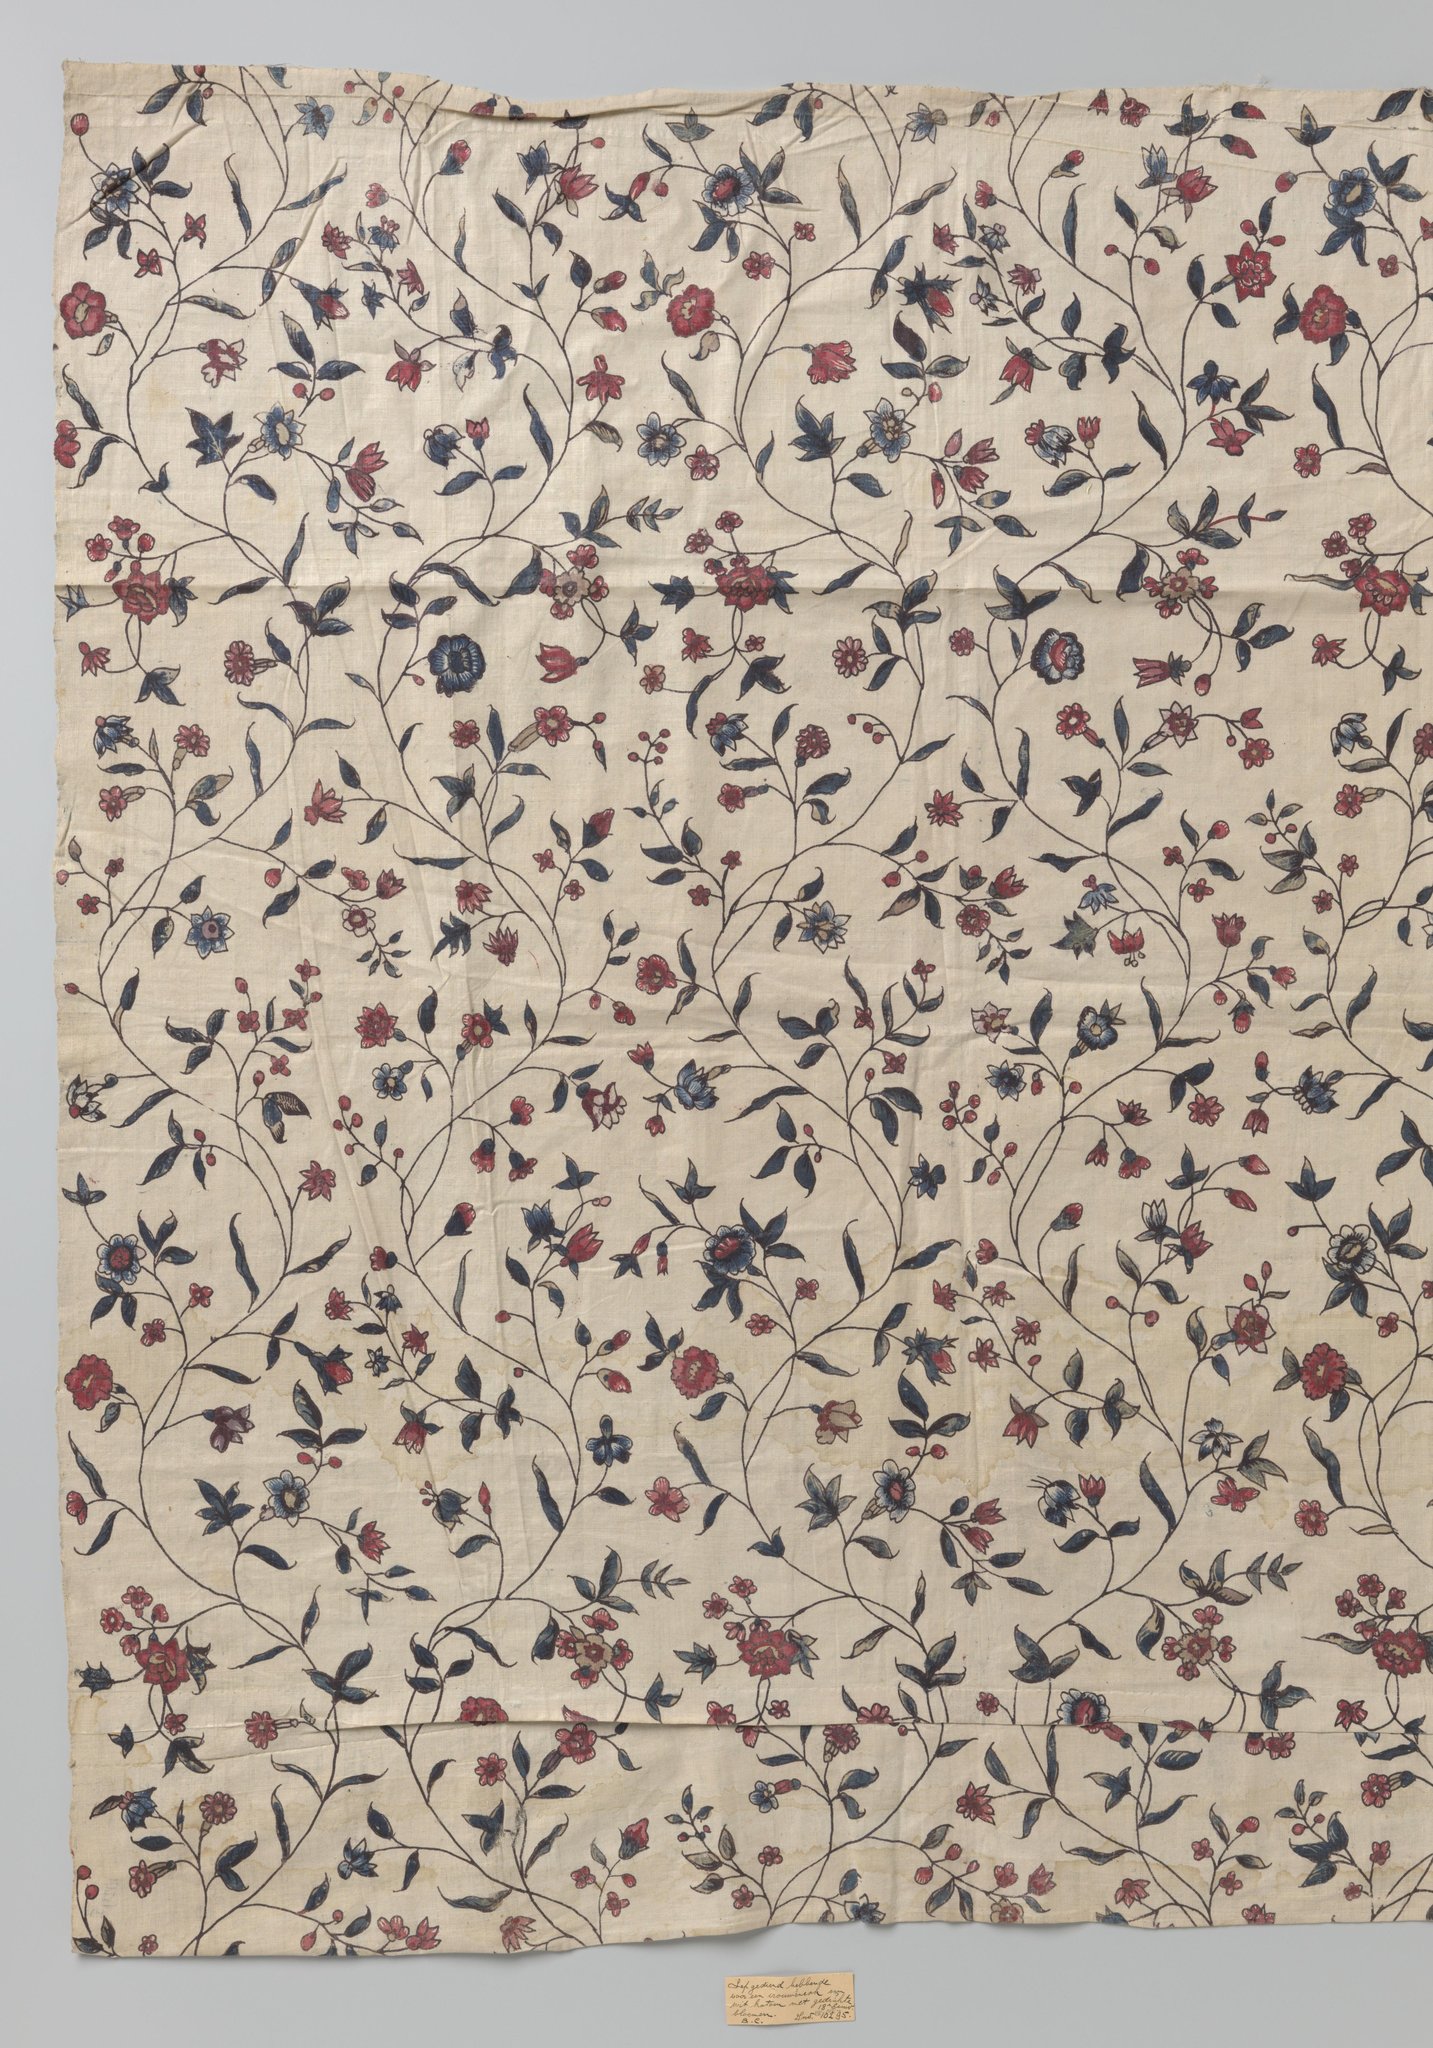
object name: lap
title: Lap van katoen met opgedrukte bloemen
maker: Anonymous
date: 1700-1800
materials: cotton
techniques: printing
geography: netherlands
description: Lap van katoen met opgedrukte bloemen. Voor de vervaardiging van een vrouwenjak.